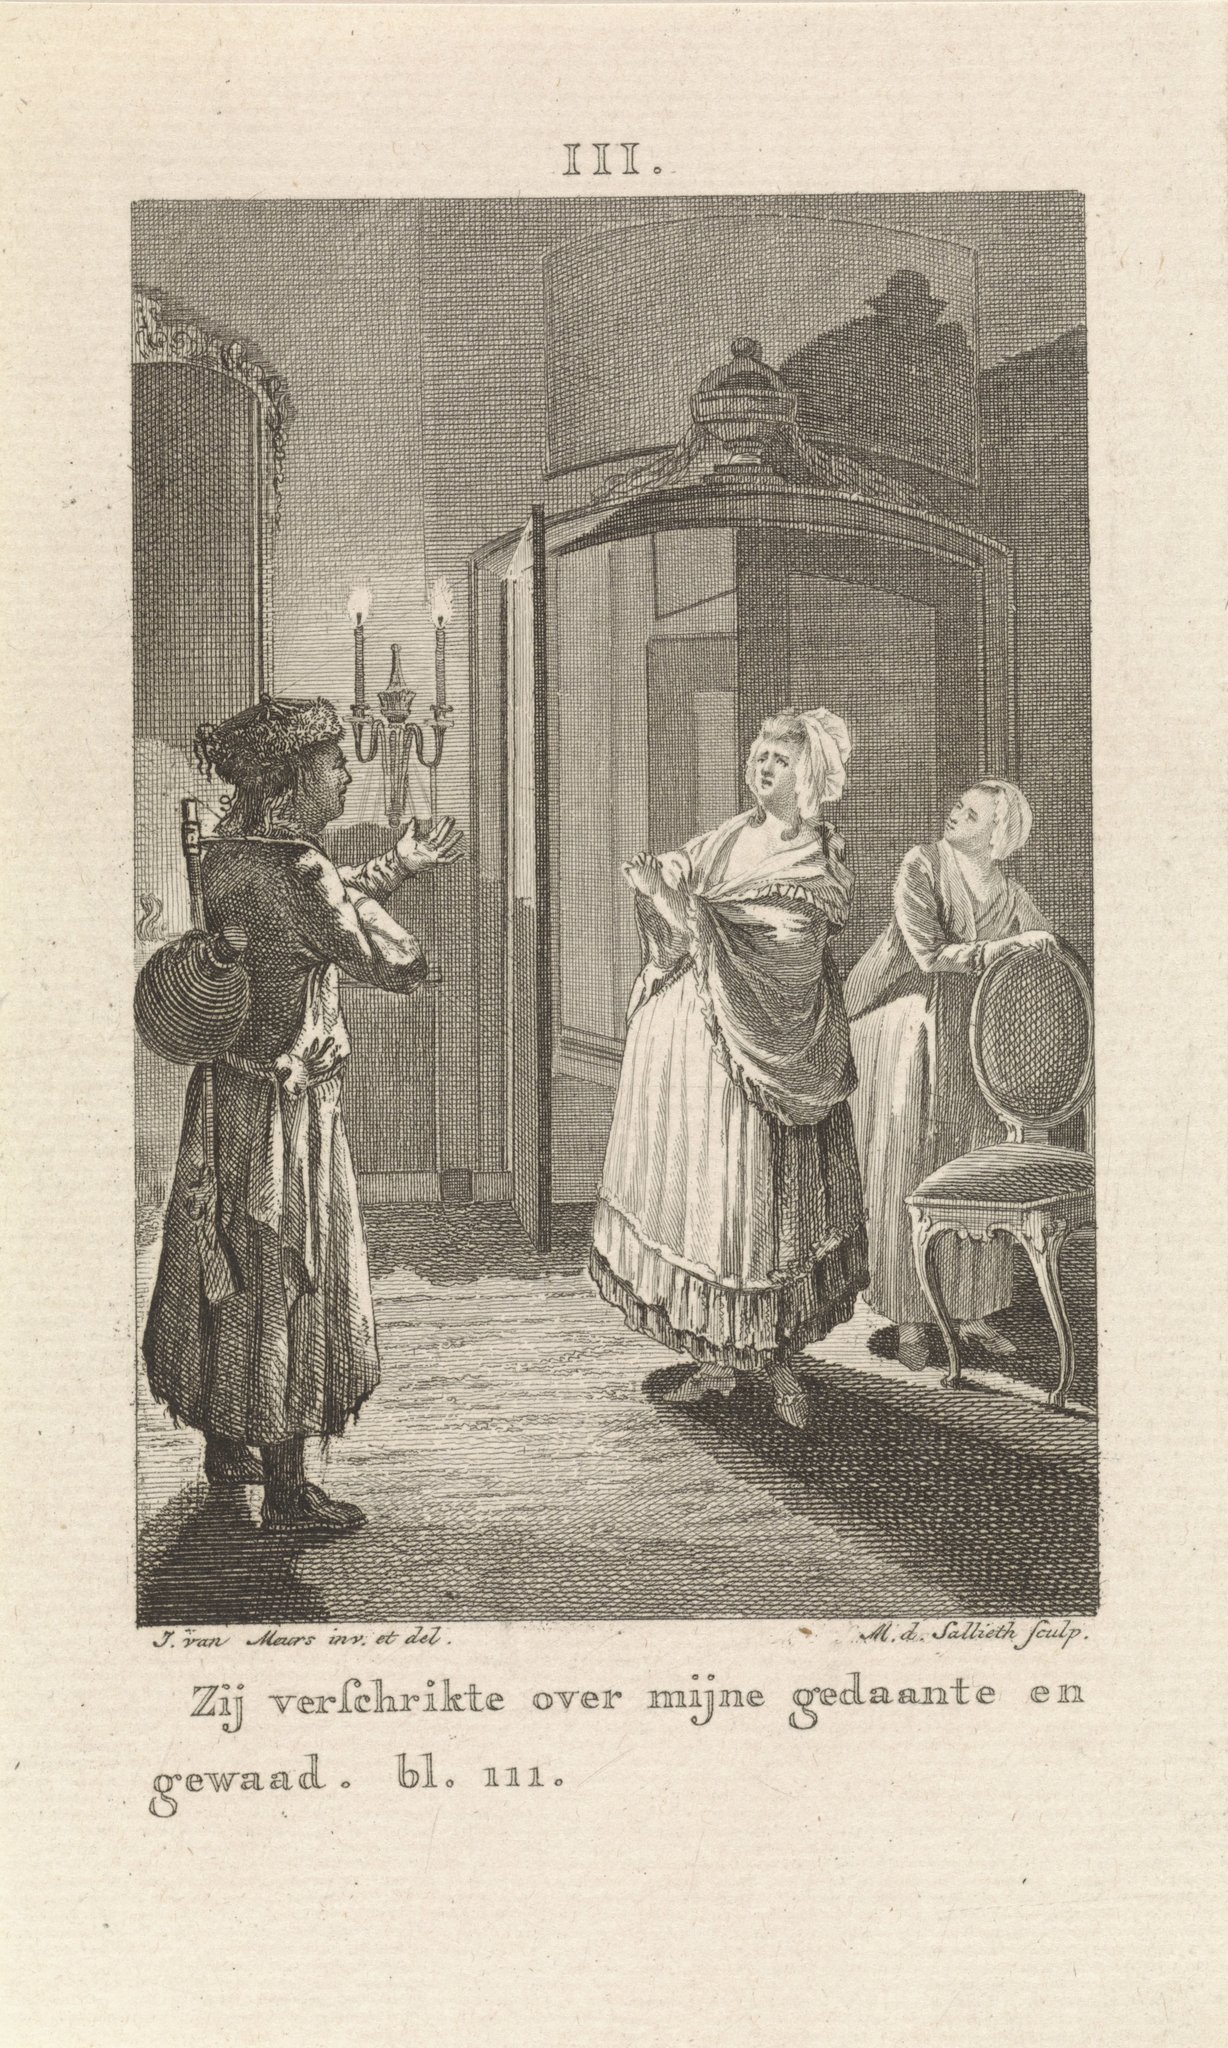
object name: book illustration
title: Maria en Friedrichs zus schrikken van zijn toestand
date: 1788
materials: paper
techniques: engraving, etching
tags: interior of the house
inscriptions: collector's mark: Lugt 2228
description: Na uit het fort van Glatz (Klodzko) te zijn ontsnapt en een lange tocht te hebben afgelegd, klopt Friedrich von der Trenck aan bij zijn zus. Maria, een bekende van de familie, en zijn zus herkennen hem in eerste instantie niet door zijn armoedige kleding. Prent middenboven genummerd: III.